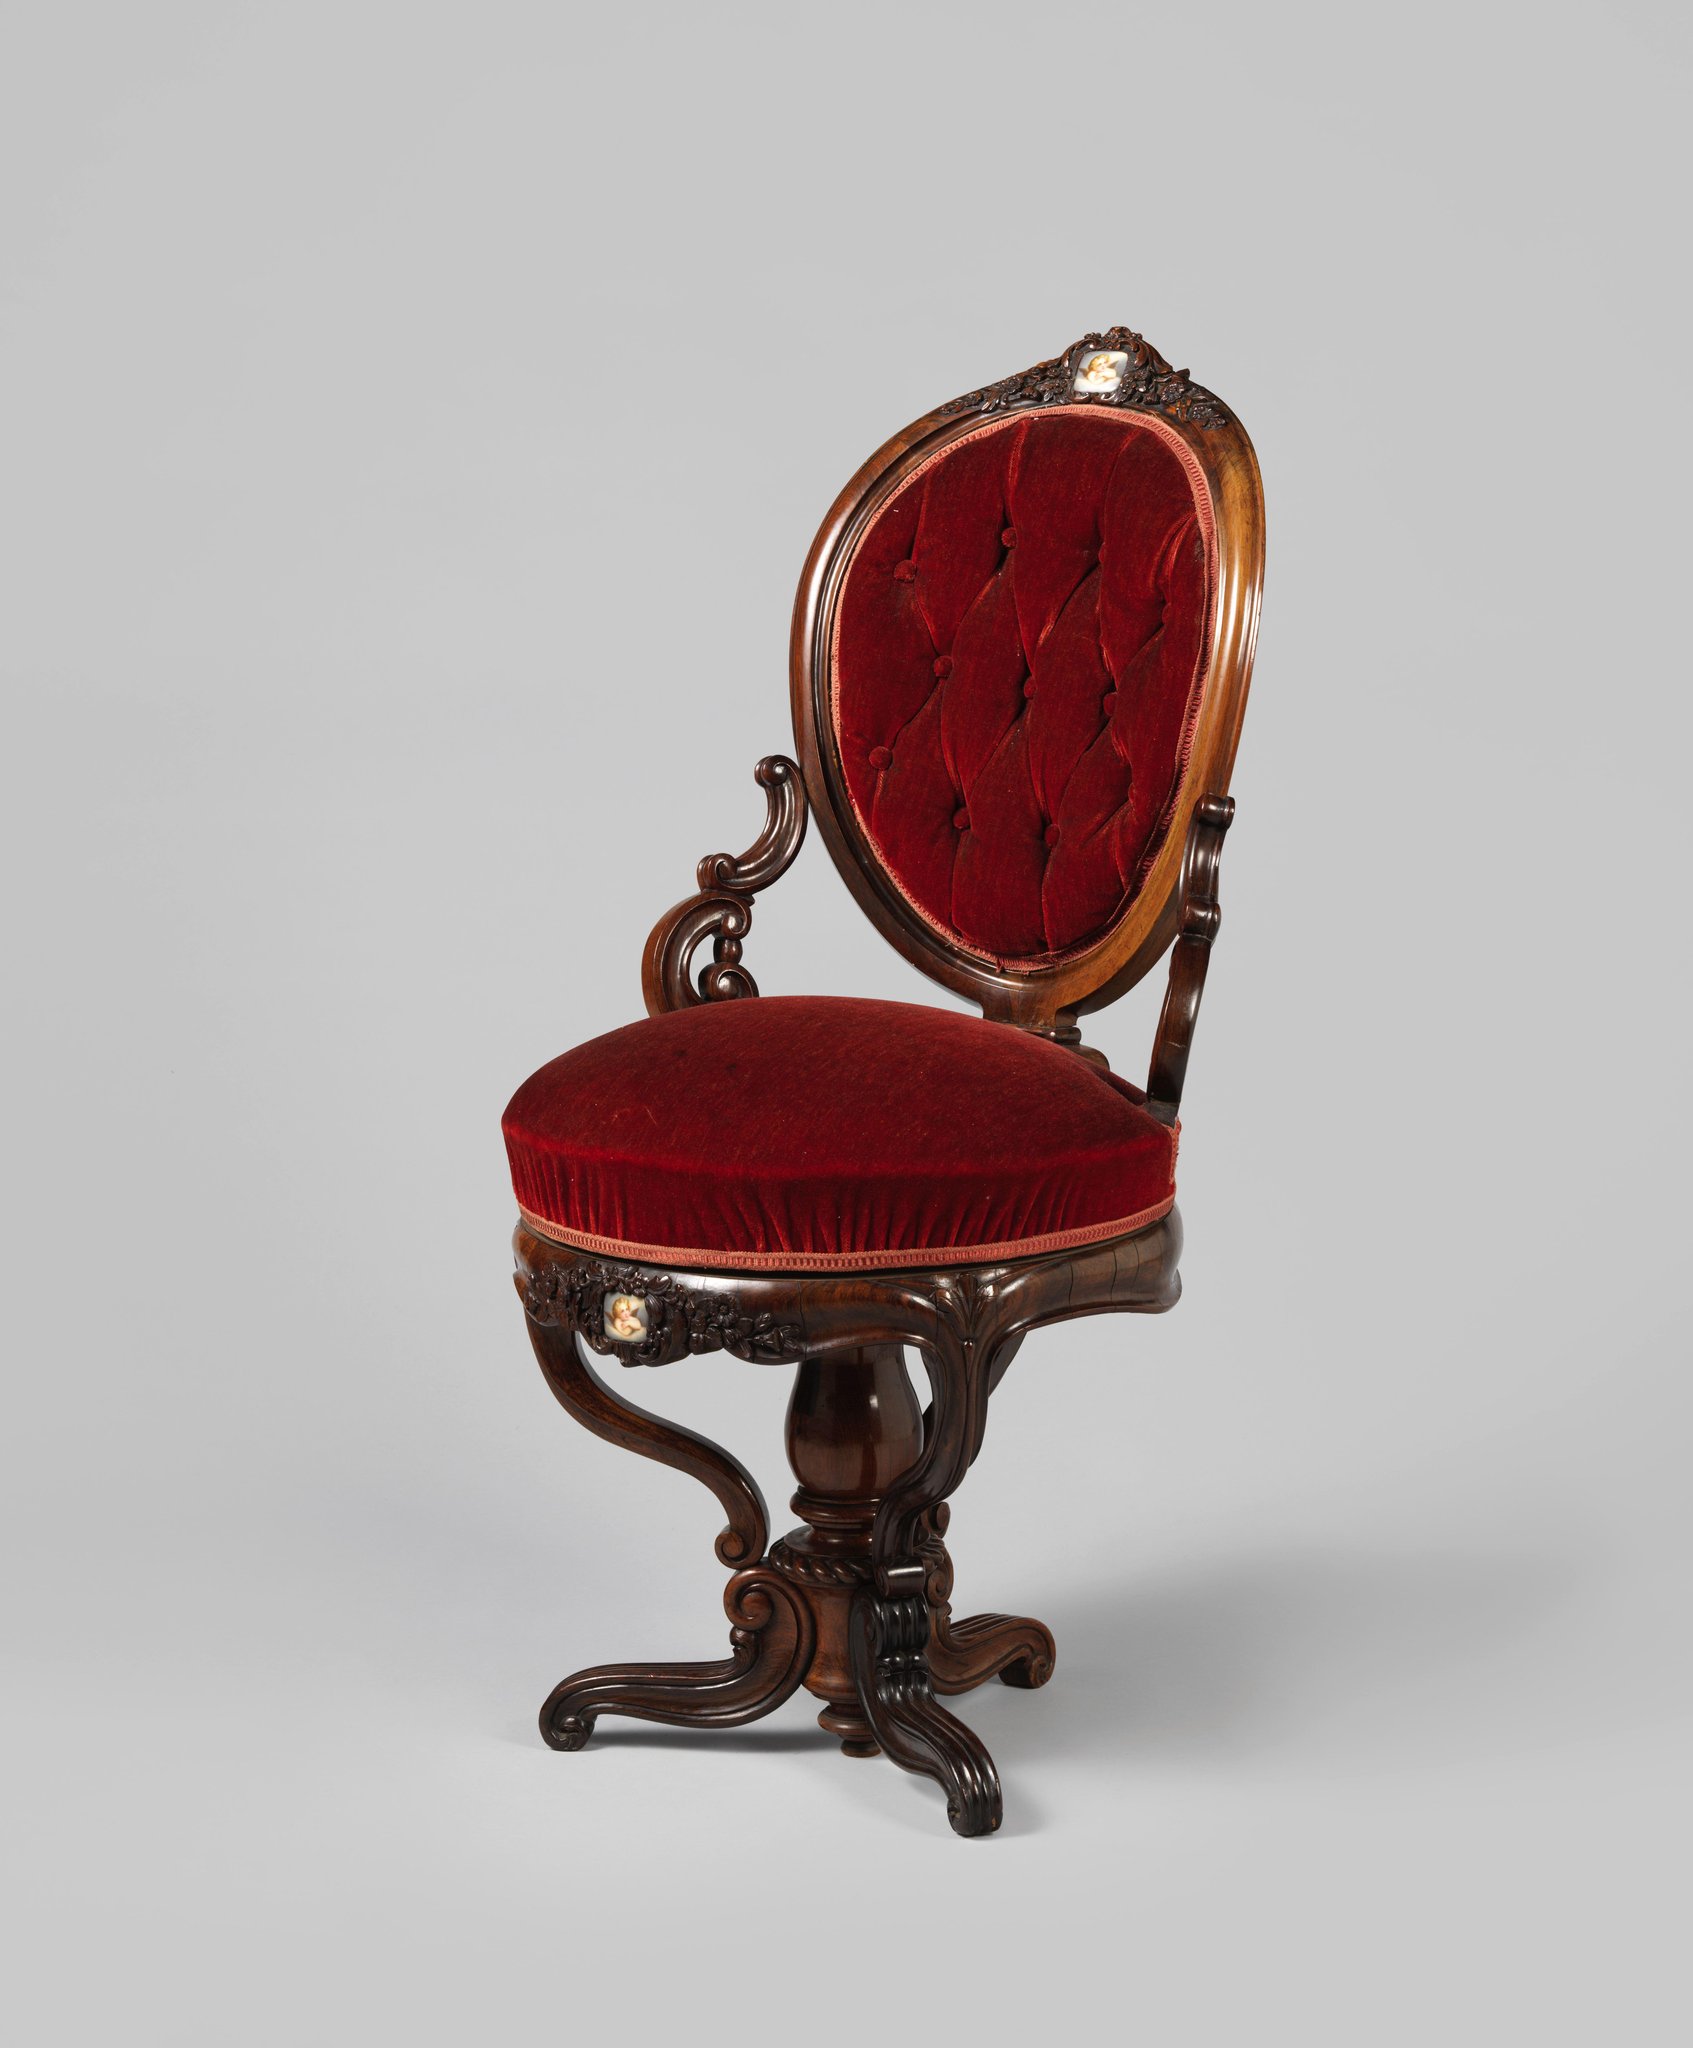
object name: music chair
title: Pianostoel van palissander bekleed met rode velours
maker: Anonymous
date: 1860-1890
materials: wood, velvet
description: Pianostoel van palissander bekleed met rode velours. De stoel heeft een brandmerk M.